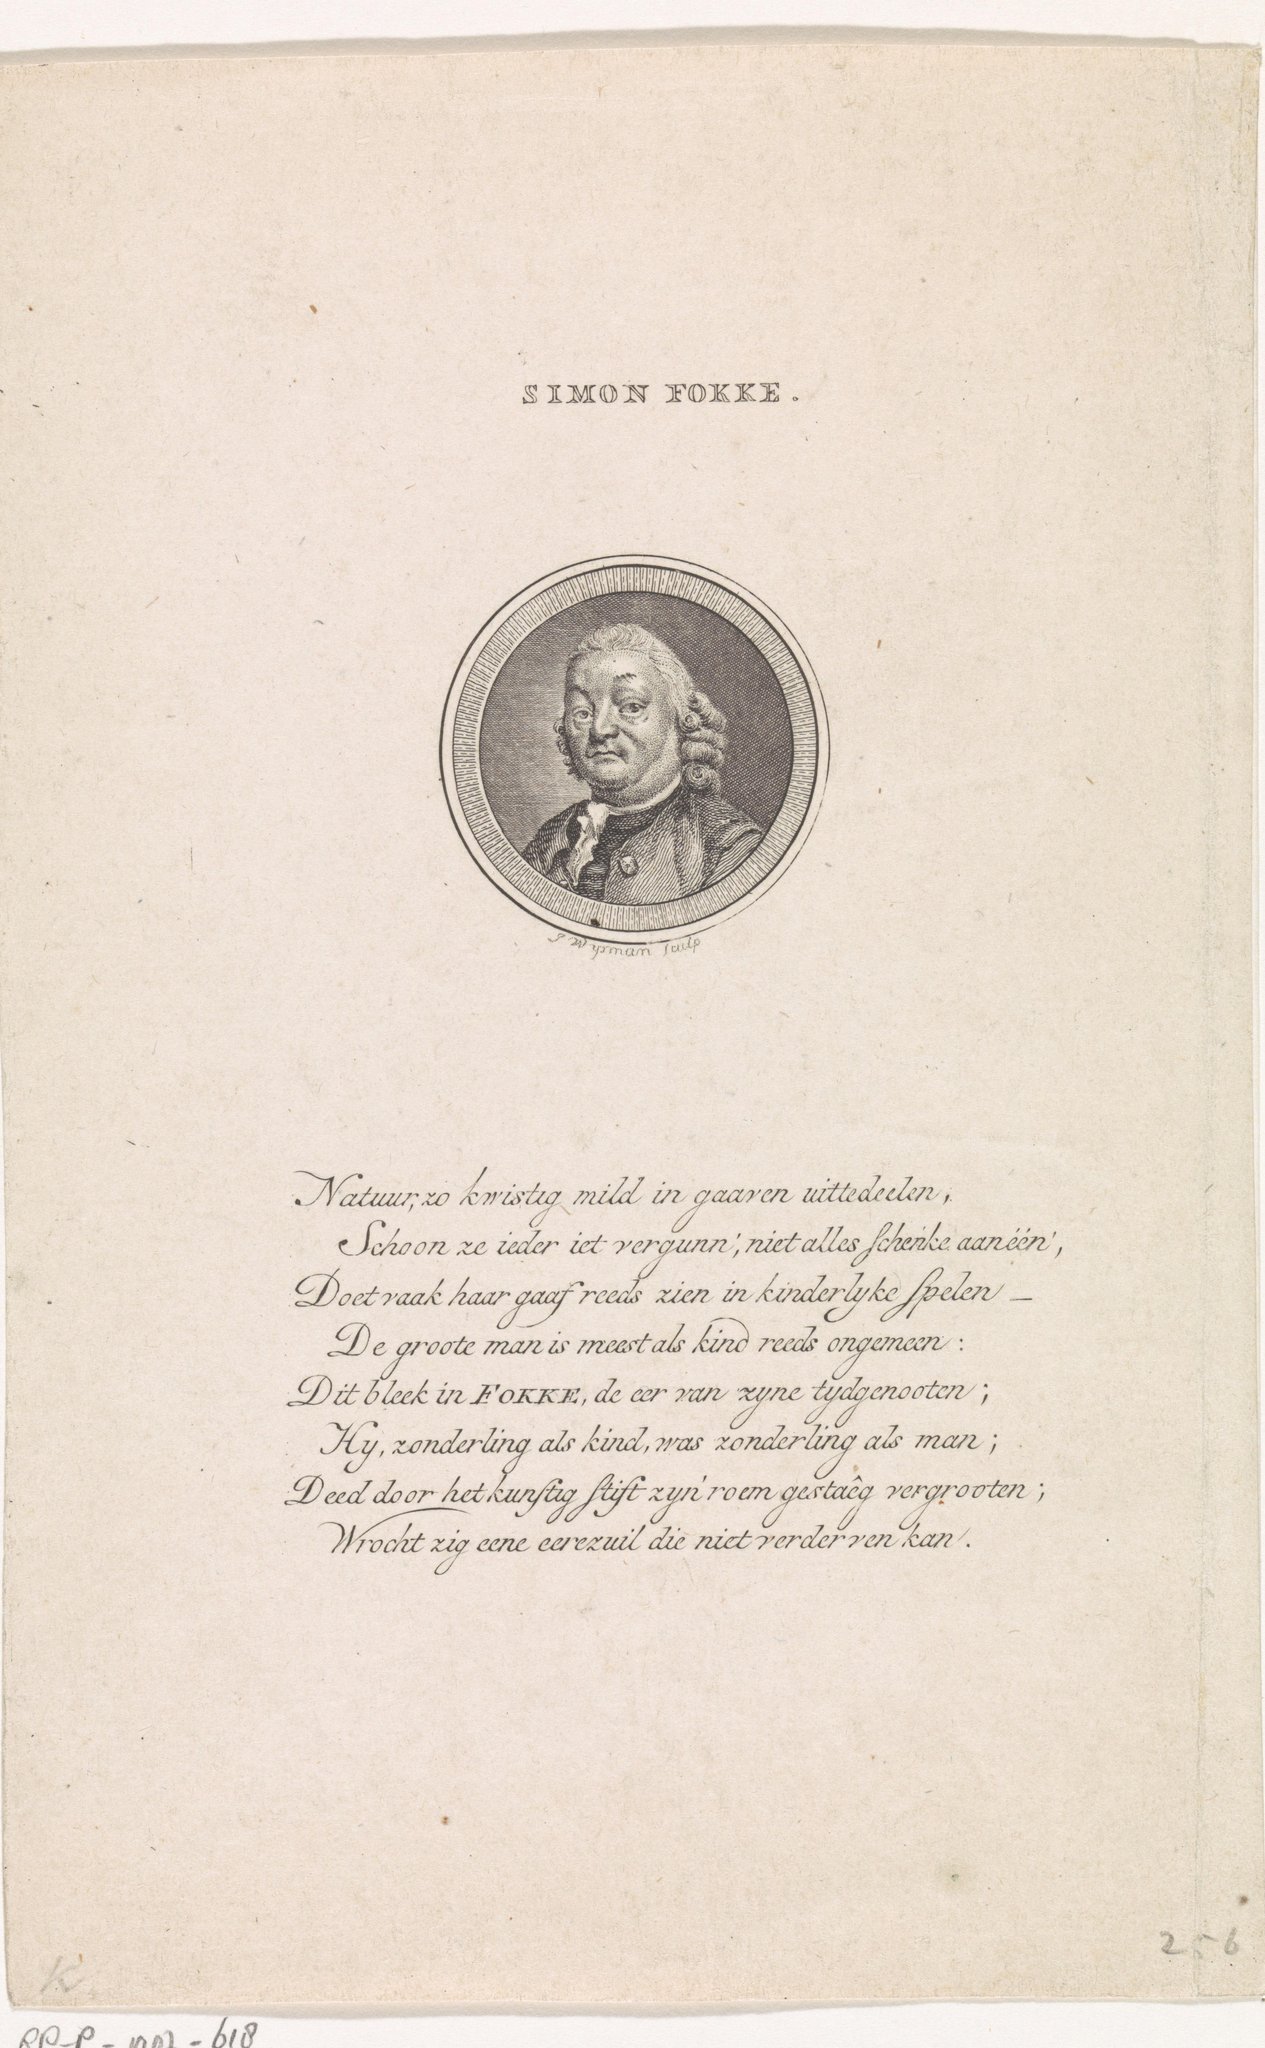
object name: print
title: Portret van Simon Fokke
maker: jacobus wijsman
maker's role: print maker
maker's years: 1768-1827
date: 1796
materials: paper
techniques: engraving, etching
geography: amsterdam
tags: print maker, draughtsman, simon fokke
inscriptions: collector's mark: Lugt 2228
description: Portret van kunstenaar Simon Fokke in een medaillon. Onder het portret een achtregelig vers in het Nederlands.